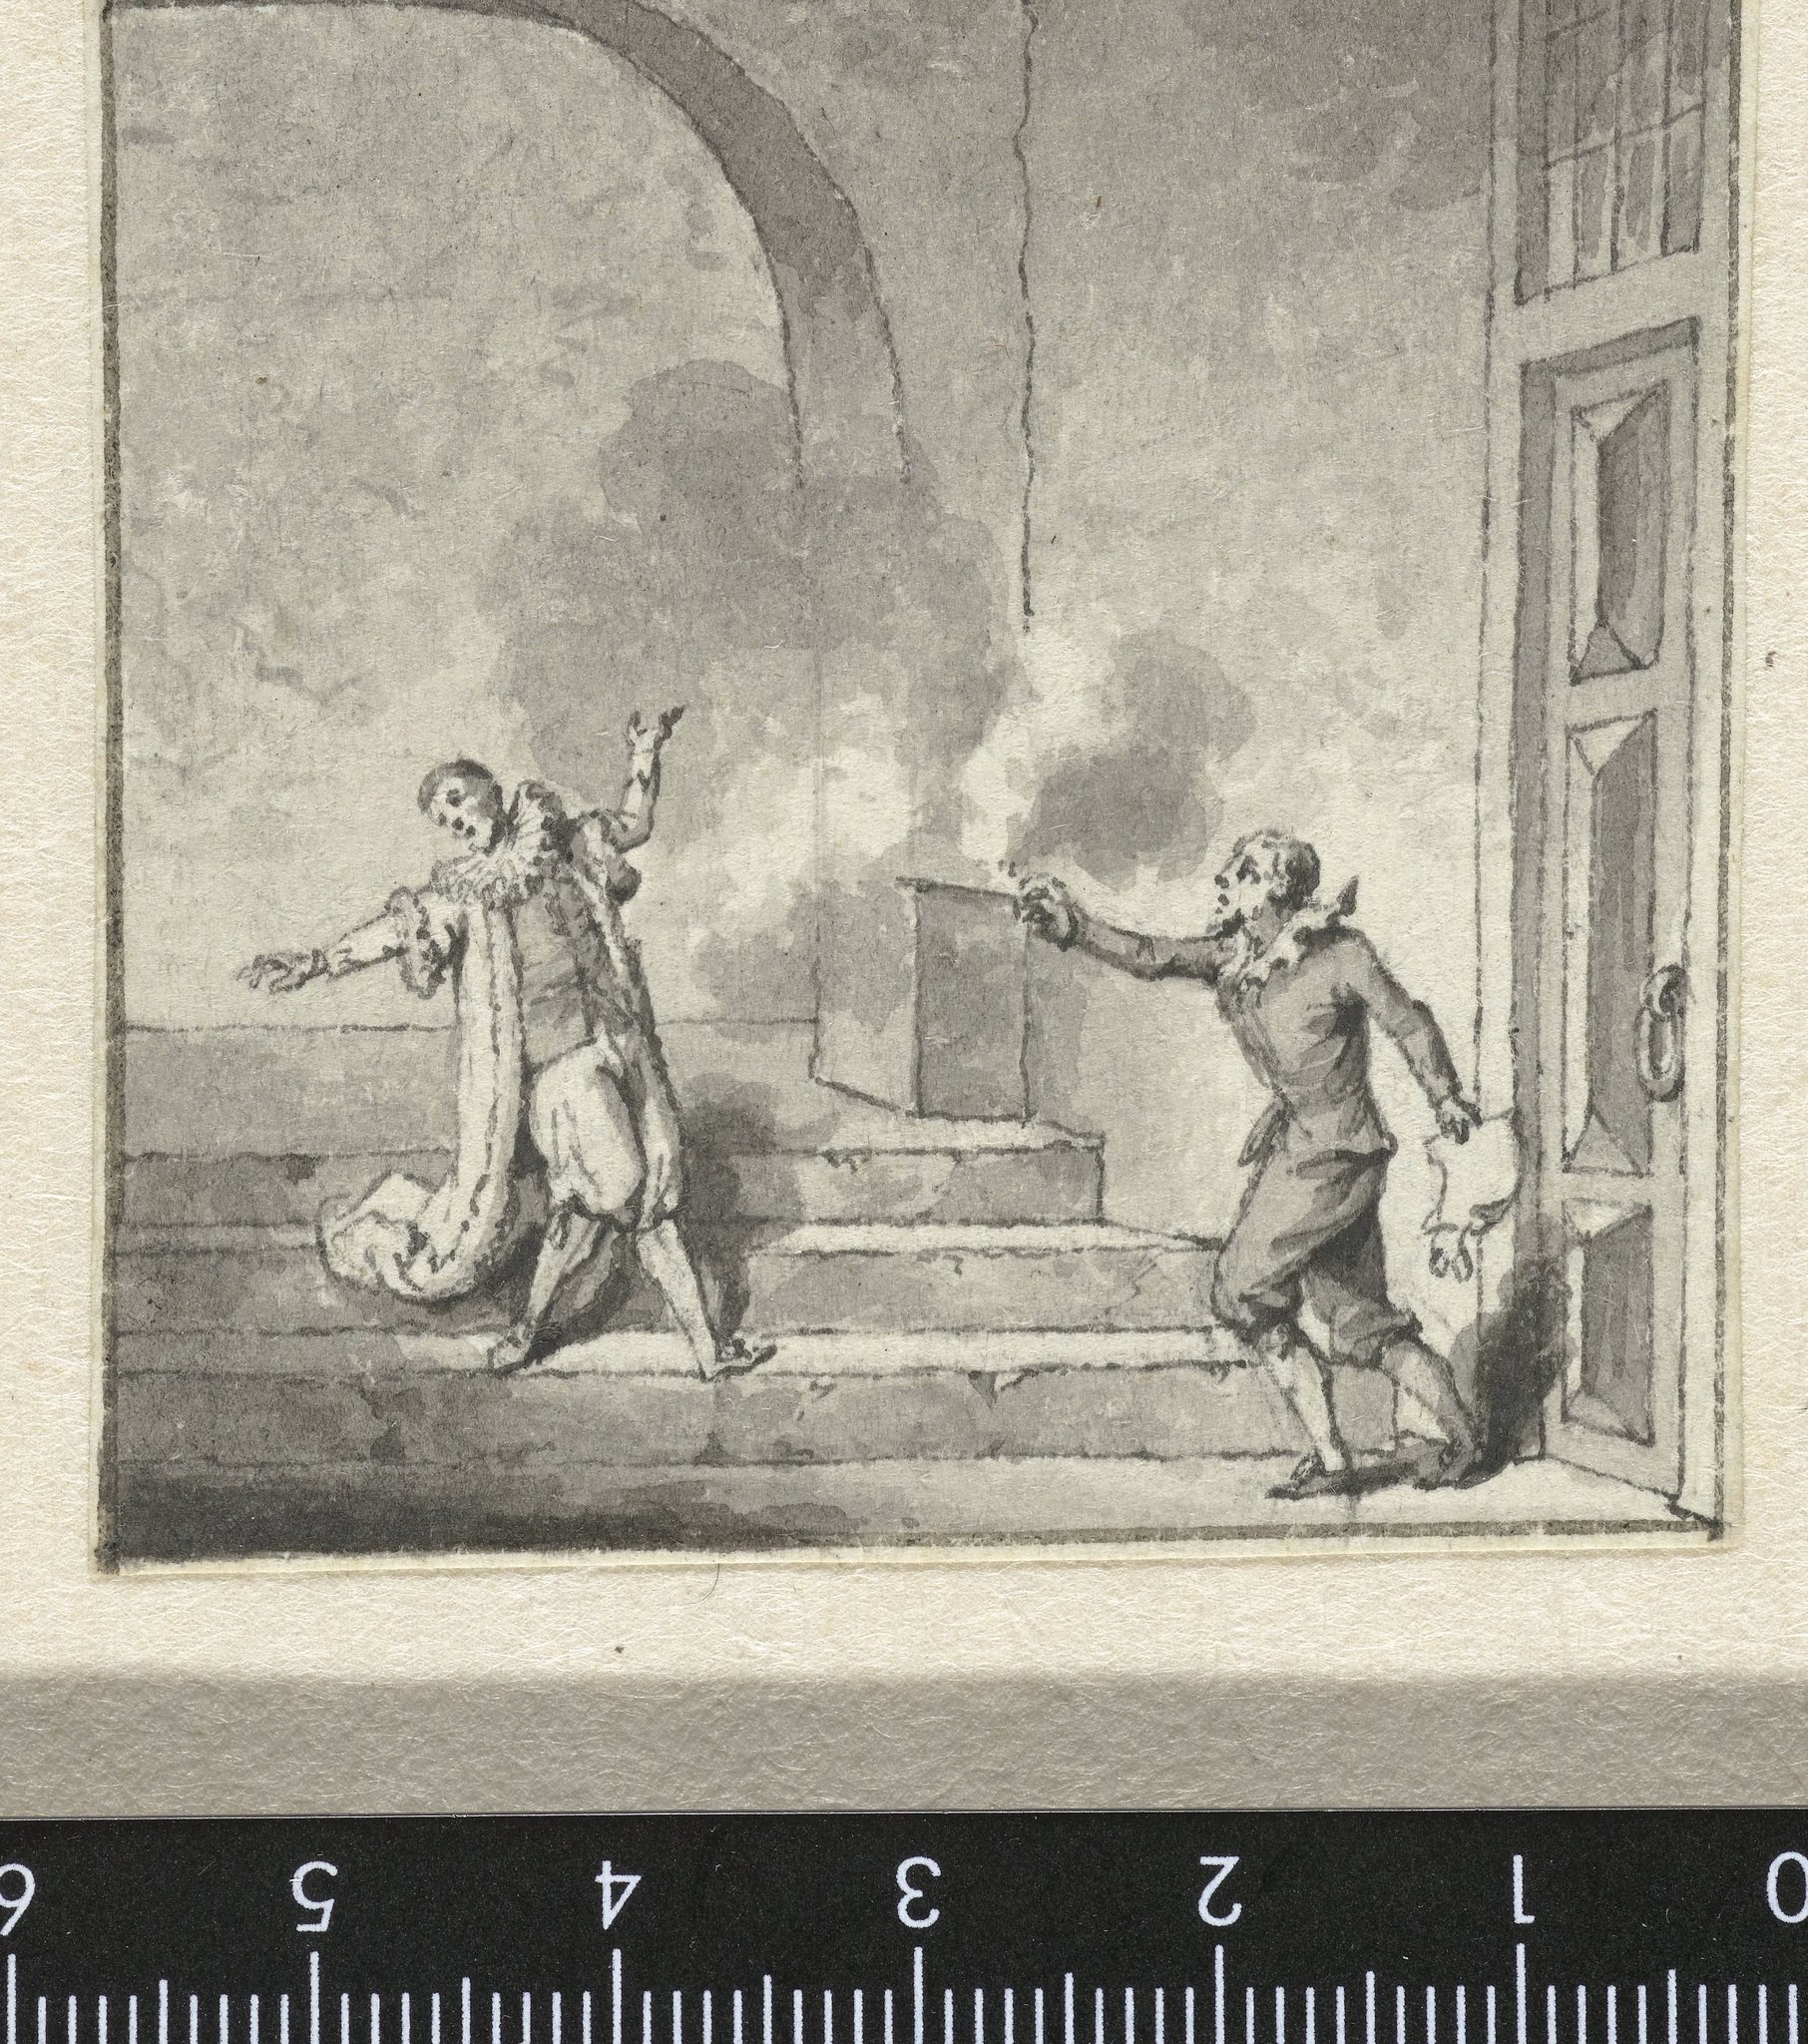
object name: drawing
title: In 't Jaar 1584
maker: Anonymous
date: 1789-1810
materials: ink, paper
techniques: brush, pen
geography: netherlands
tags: william i (prince of orange), attempt, political murder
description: Moord op Willem van Oranje, 10 juli 1584.